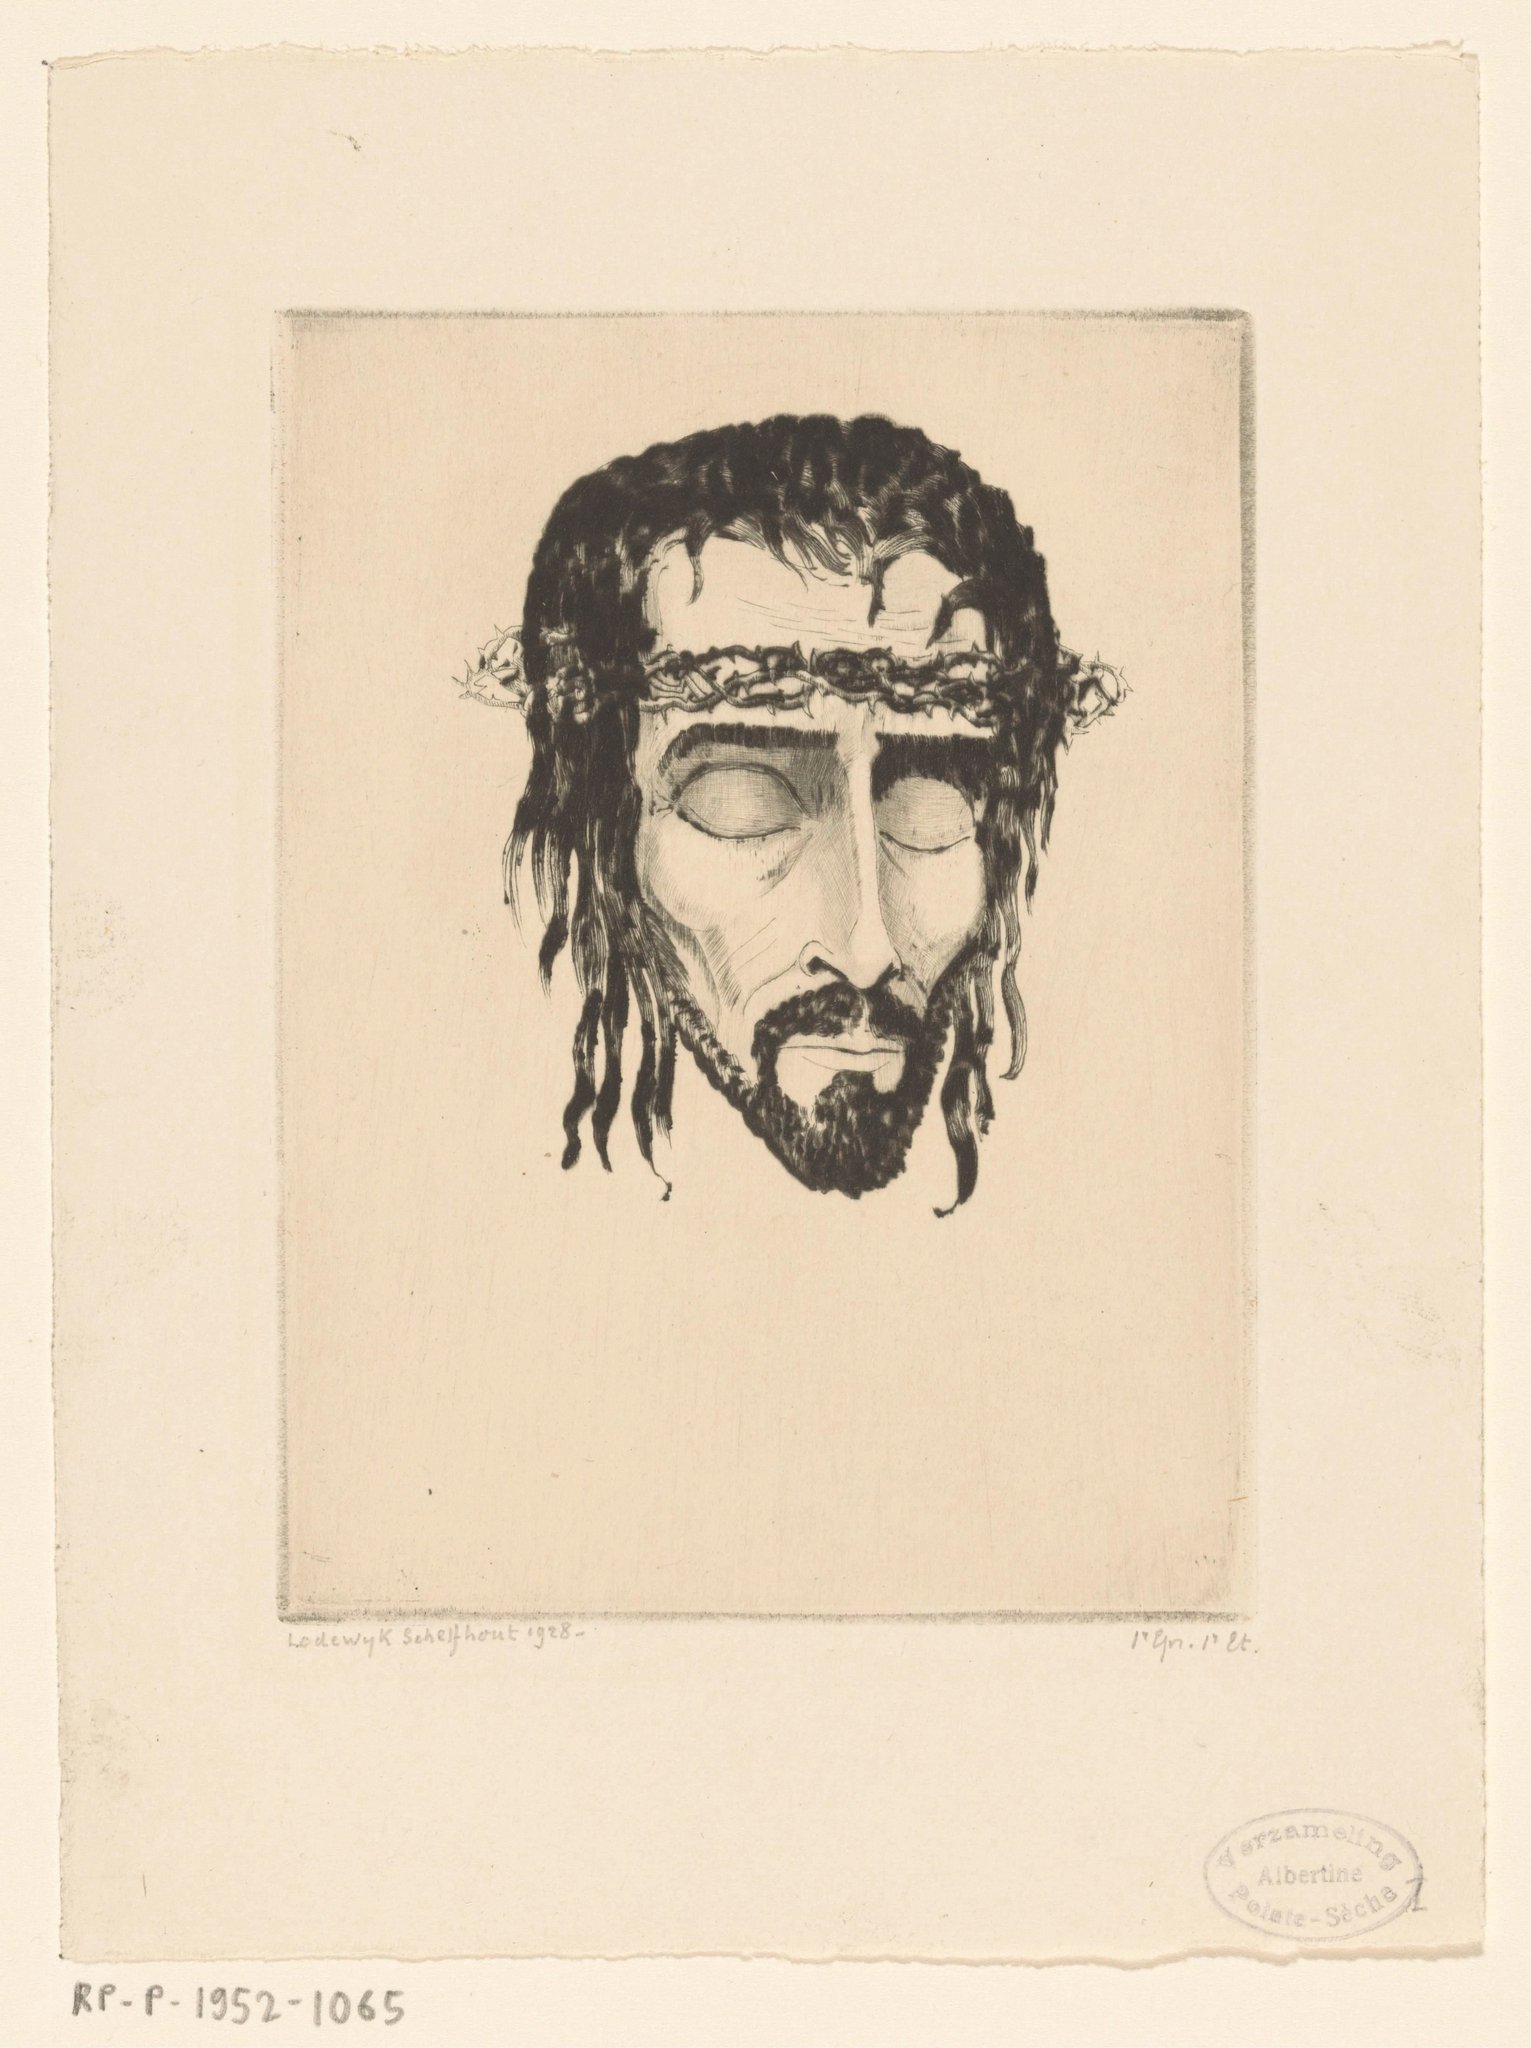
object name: print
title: Tête de Christ IV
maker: lodewijk schelfhout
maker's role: draughtsman, print maker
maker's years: 1881-1943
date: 1928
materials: paper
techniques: drypoint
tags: crown of thorns ~ instruments of the passion, eyes closed, 'portraits' of christ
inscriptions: collector's mark: Lugt 5i, collector's mark: Lugt 2228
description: Christus met doornenkroon en gesloten ogen.